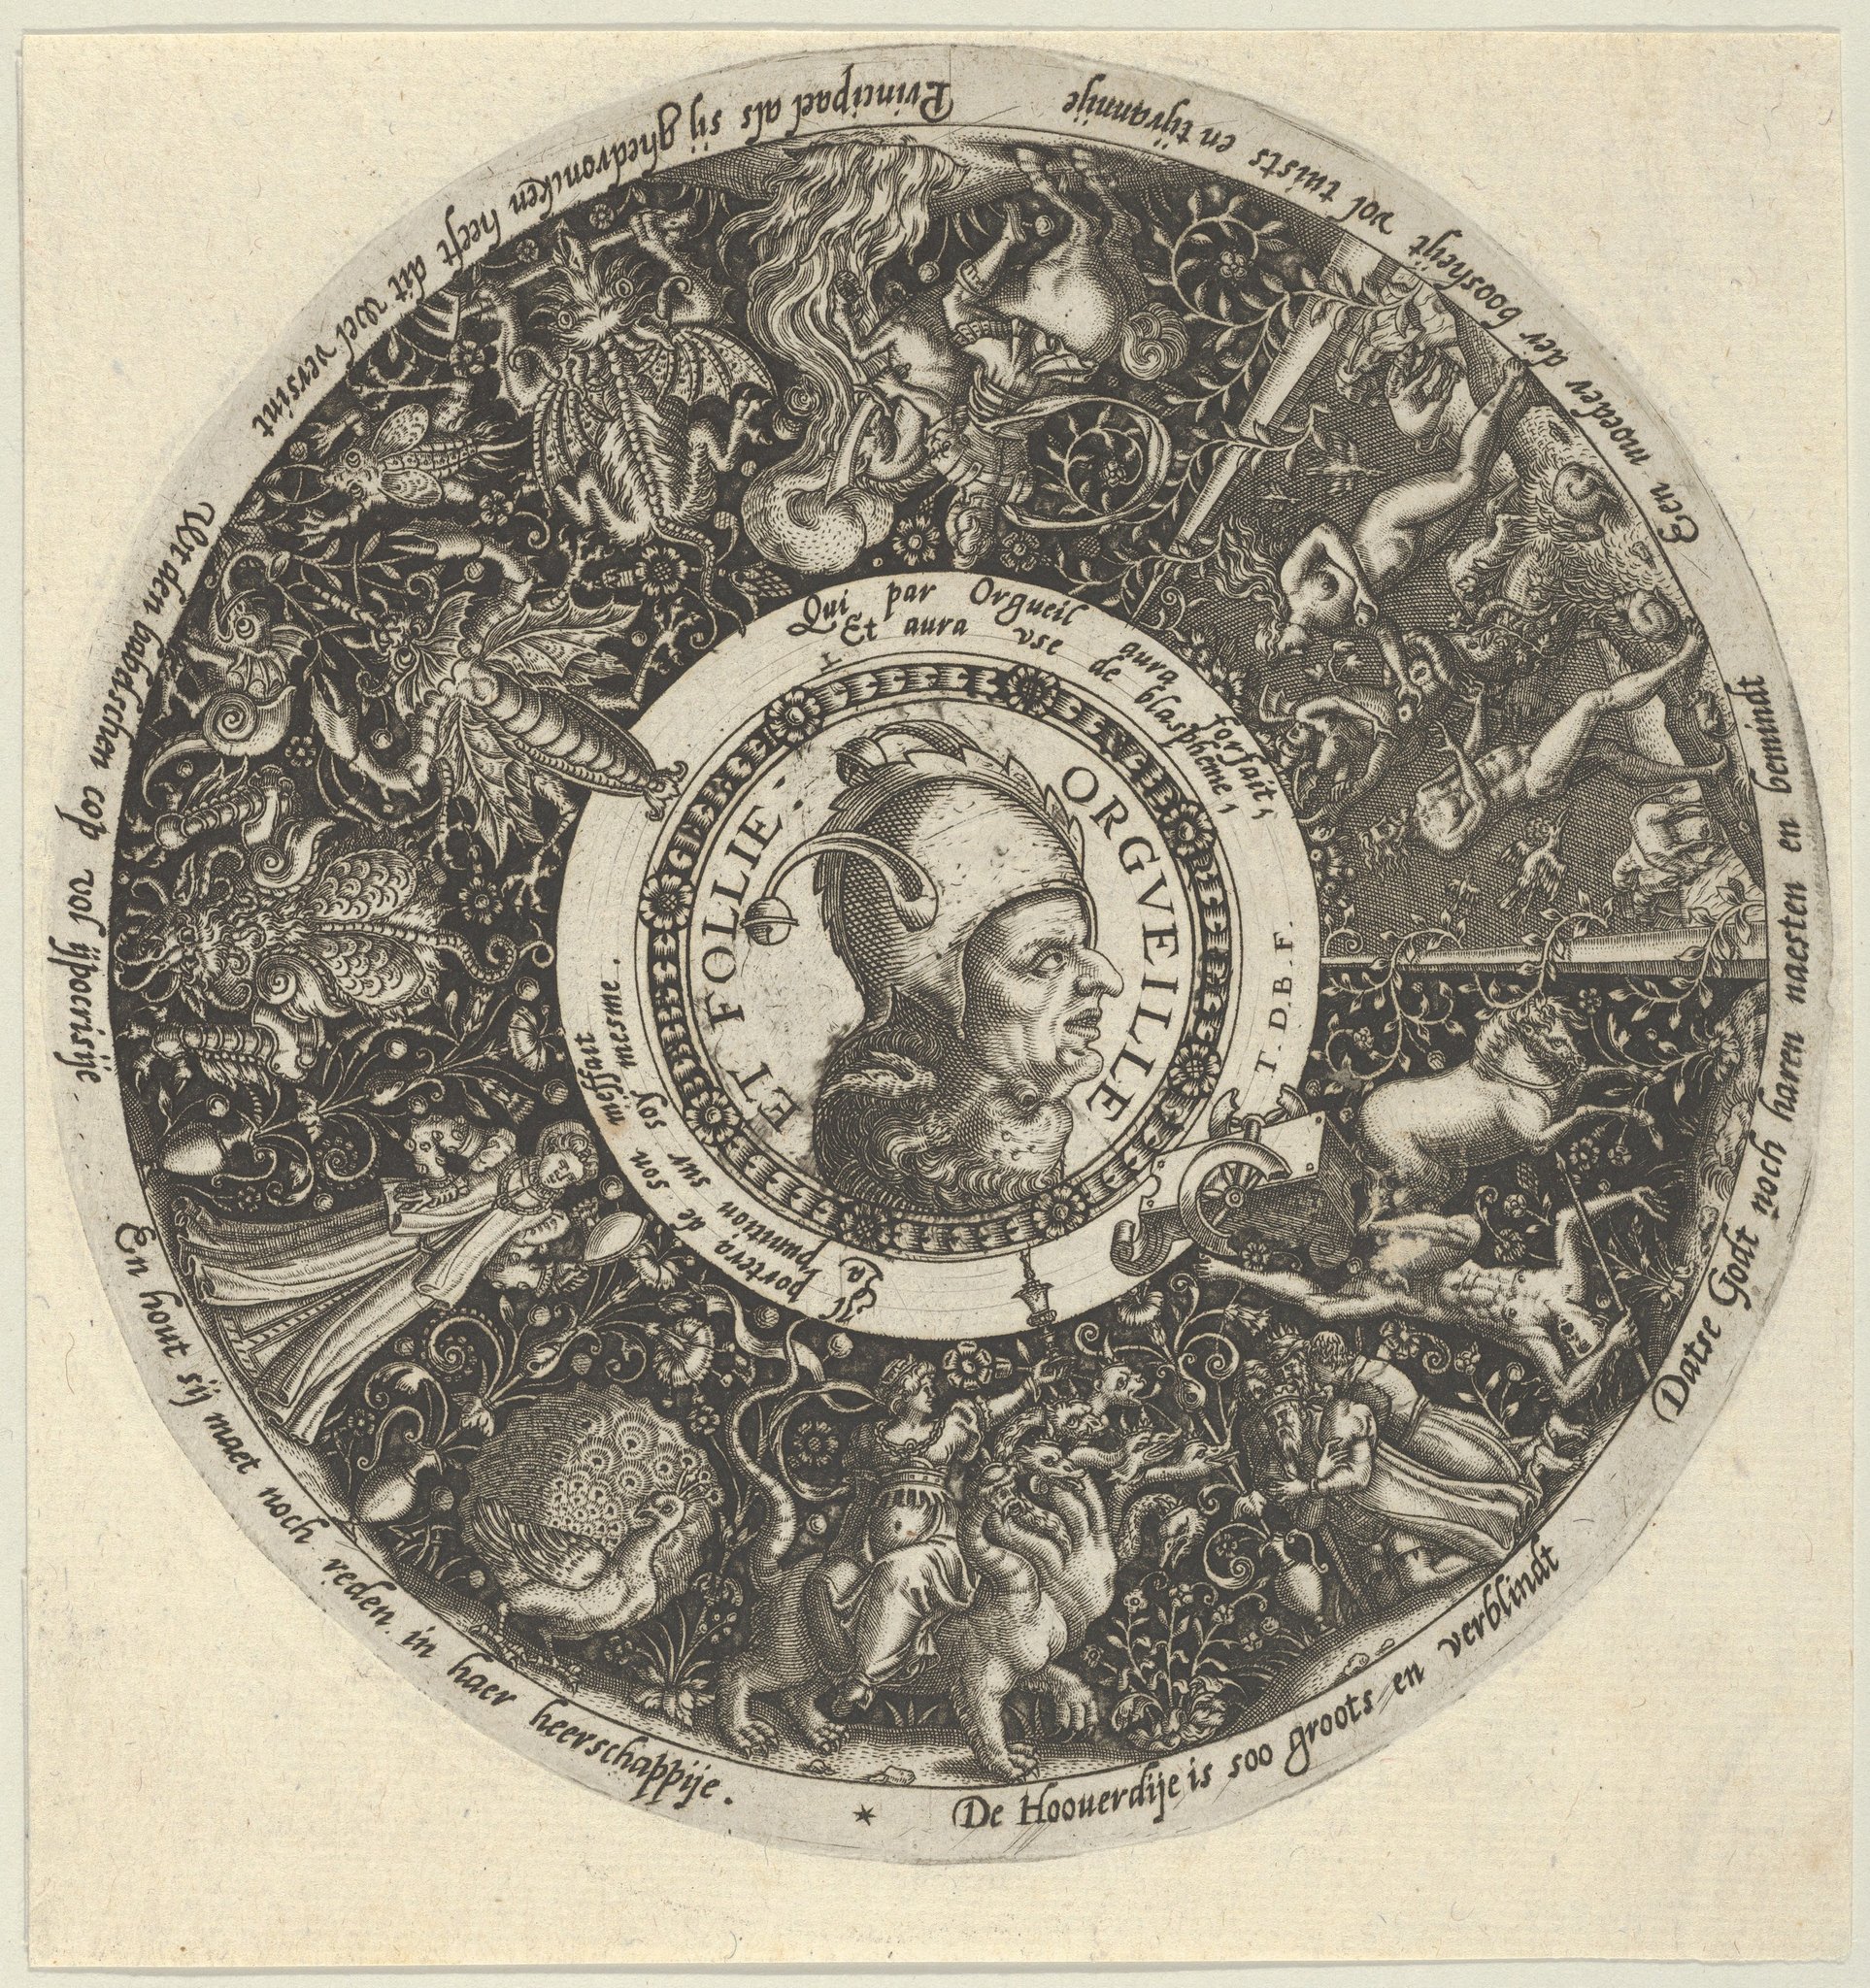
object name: print ornament architecture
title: Pride and Folly, from a Series of Tazza Designs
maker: theodor de bry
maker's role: artist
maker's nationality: netherlandish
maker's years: 1528-1598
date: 1588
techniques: engraving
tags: mythical creatures,peacocks,horses,demons,adam,eve